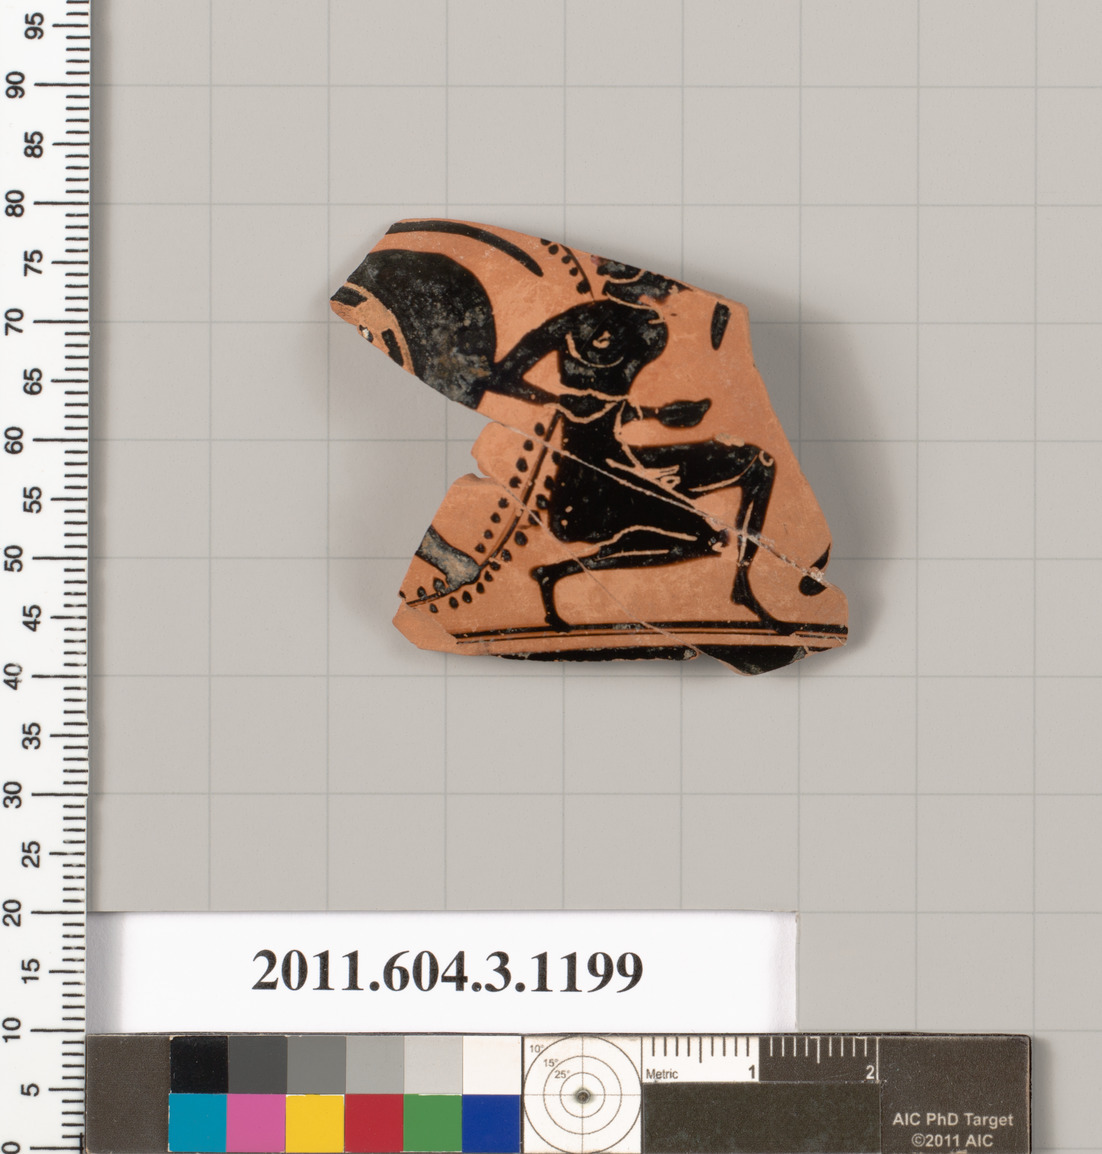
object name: mastoid fragment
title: Terracotta fragment of a mastoid (drinking cup with narrow base)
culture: greek, attic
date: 534-468 BCE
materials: terracotta